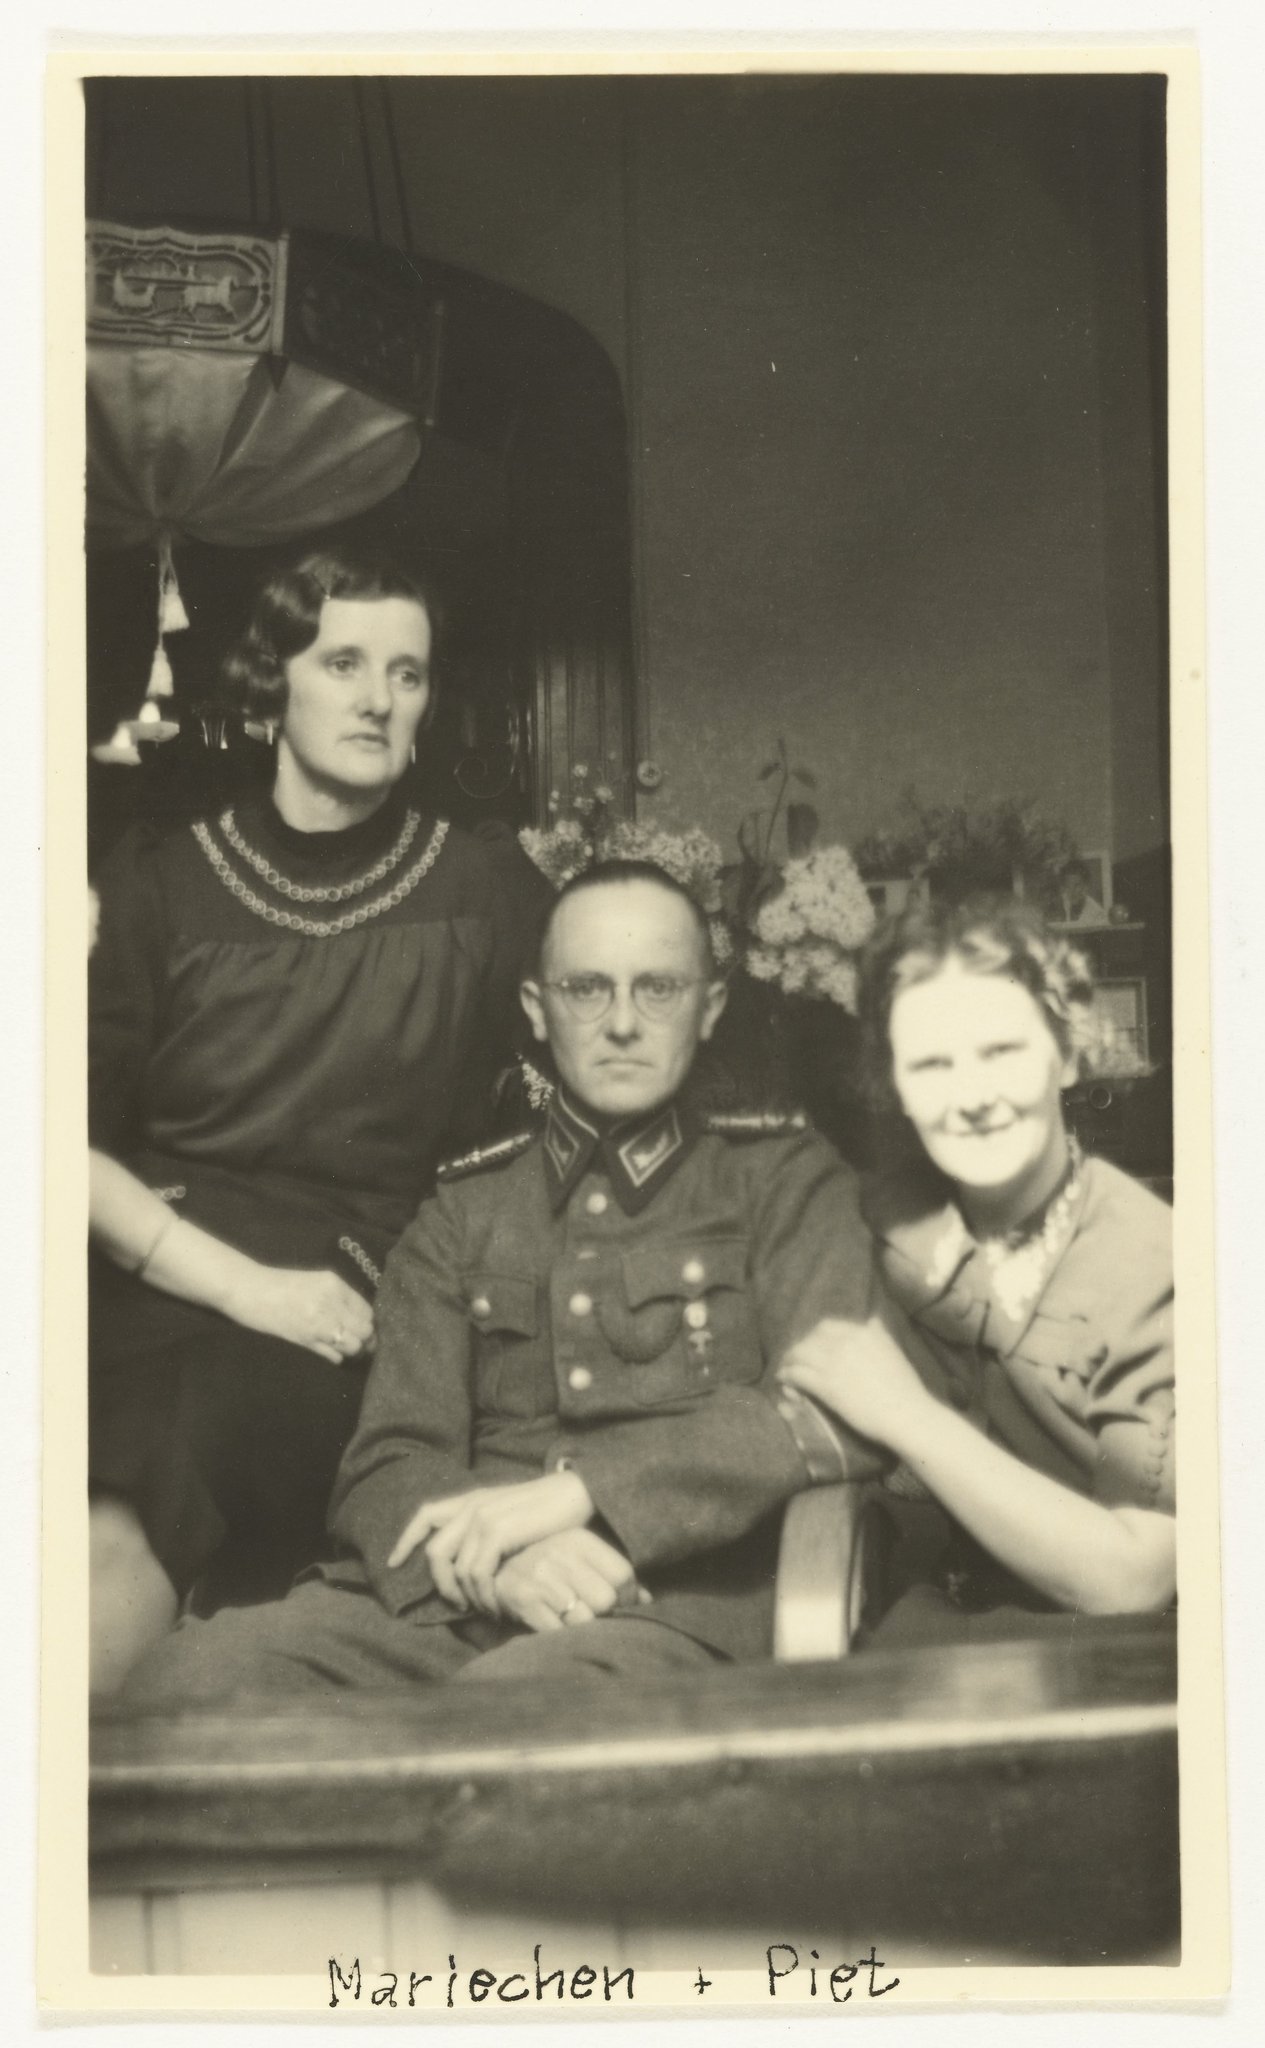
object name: photograph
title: Wehrmacht soldaat met twee Nederlandse vrouwen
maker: Anonymous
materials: photographic support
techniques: gelatin silver print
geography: hoek van holland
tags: occupier and civilians, occupation ~ war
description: Een oudere en een jongere Nederlandse vrouw poseren met een Duitse militair in een kamer. Op de voorkant staat: Mariechen en Piet.